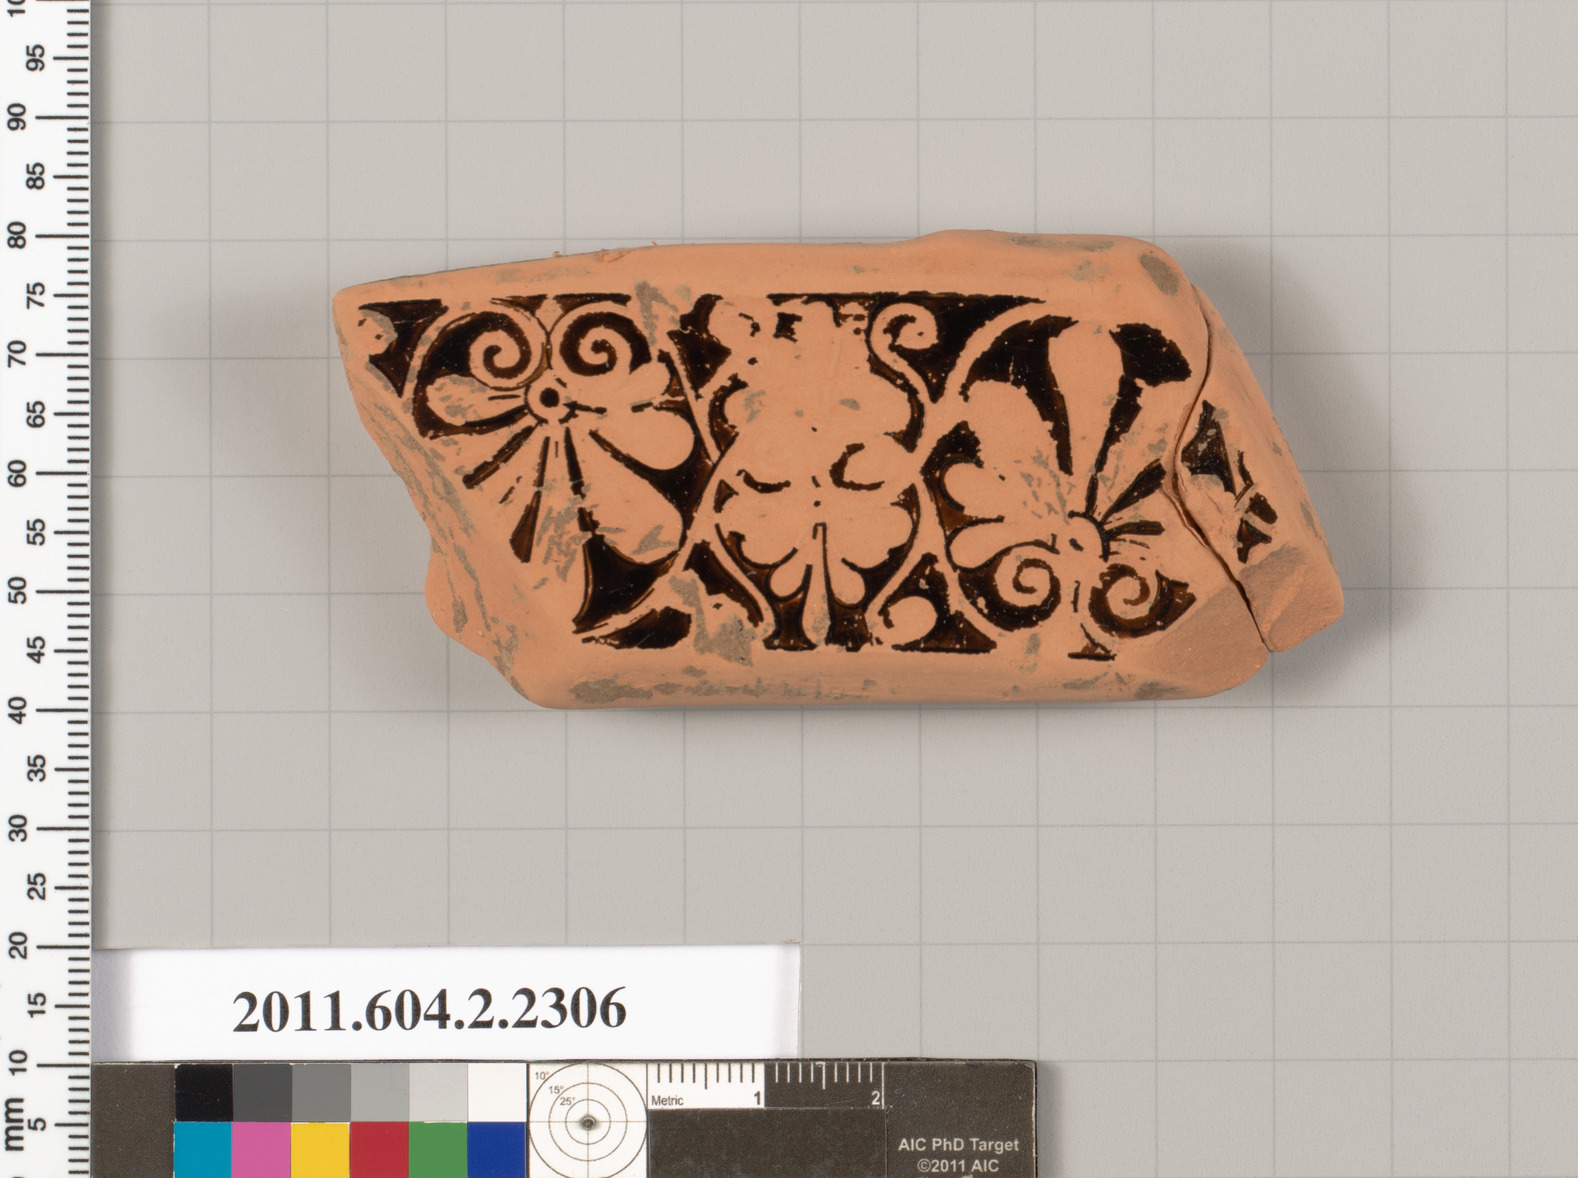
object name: calyx fragment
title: Terracotta fragment of a calyx-krater (bowl for mixing wine and water)?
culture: greek, attic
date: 480 BCE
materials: terracotta